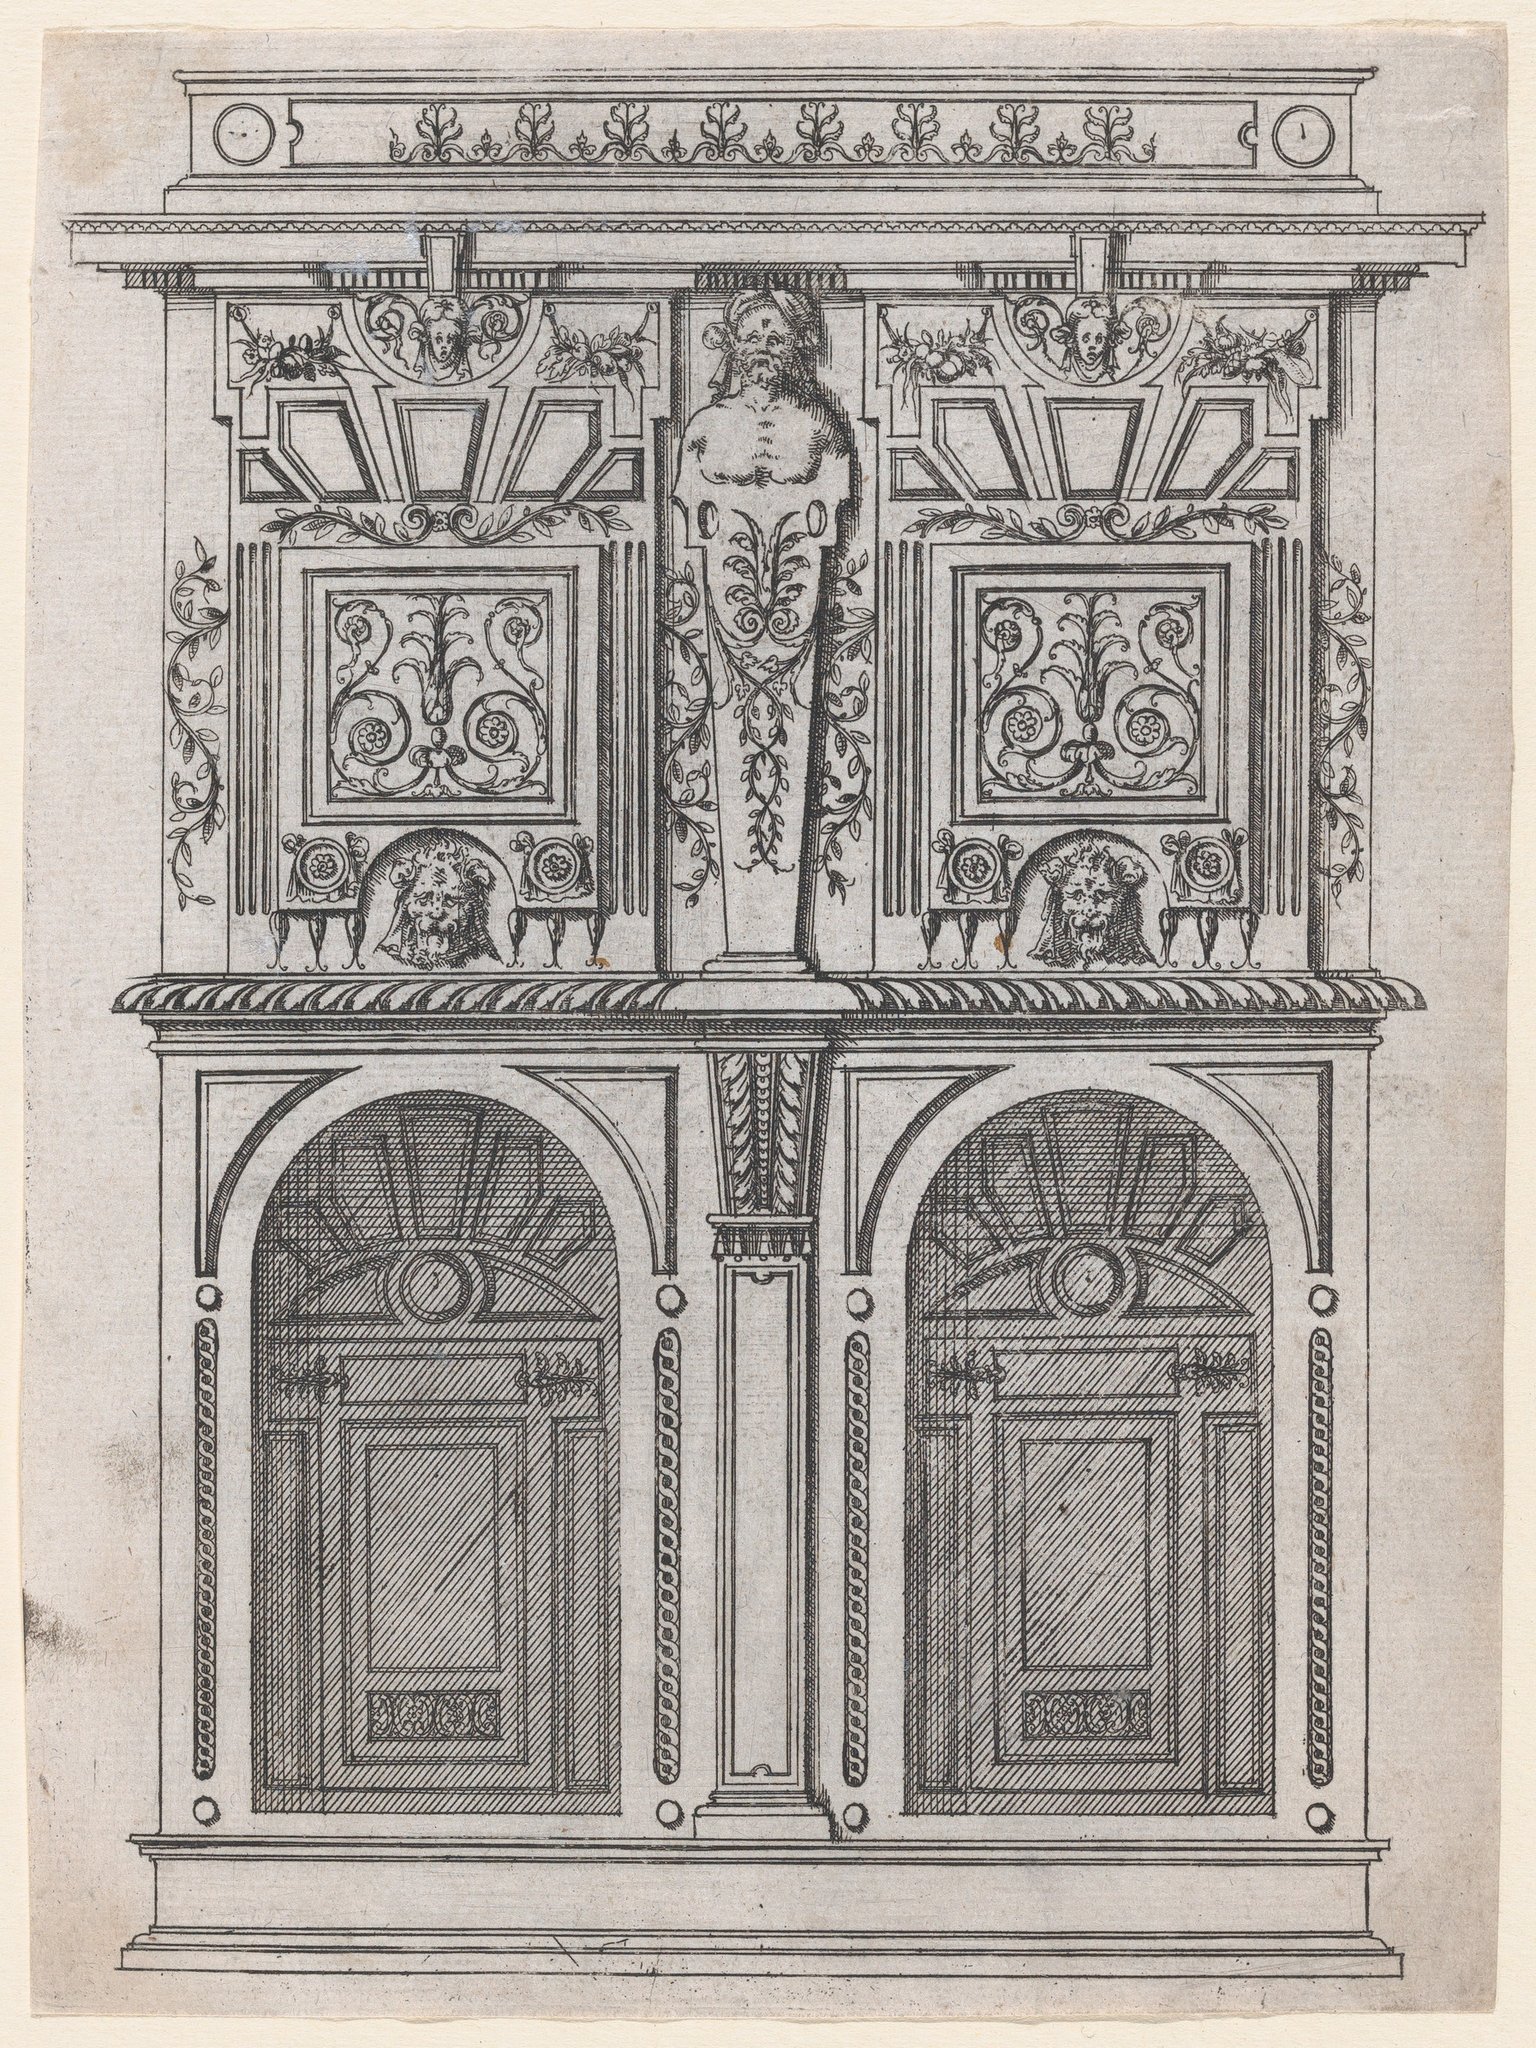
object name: print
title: Furniture Design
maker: jacques androuet du cerceau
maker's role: artist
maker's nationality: french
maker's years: 1510-1585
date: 1565-1570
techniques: etching